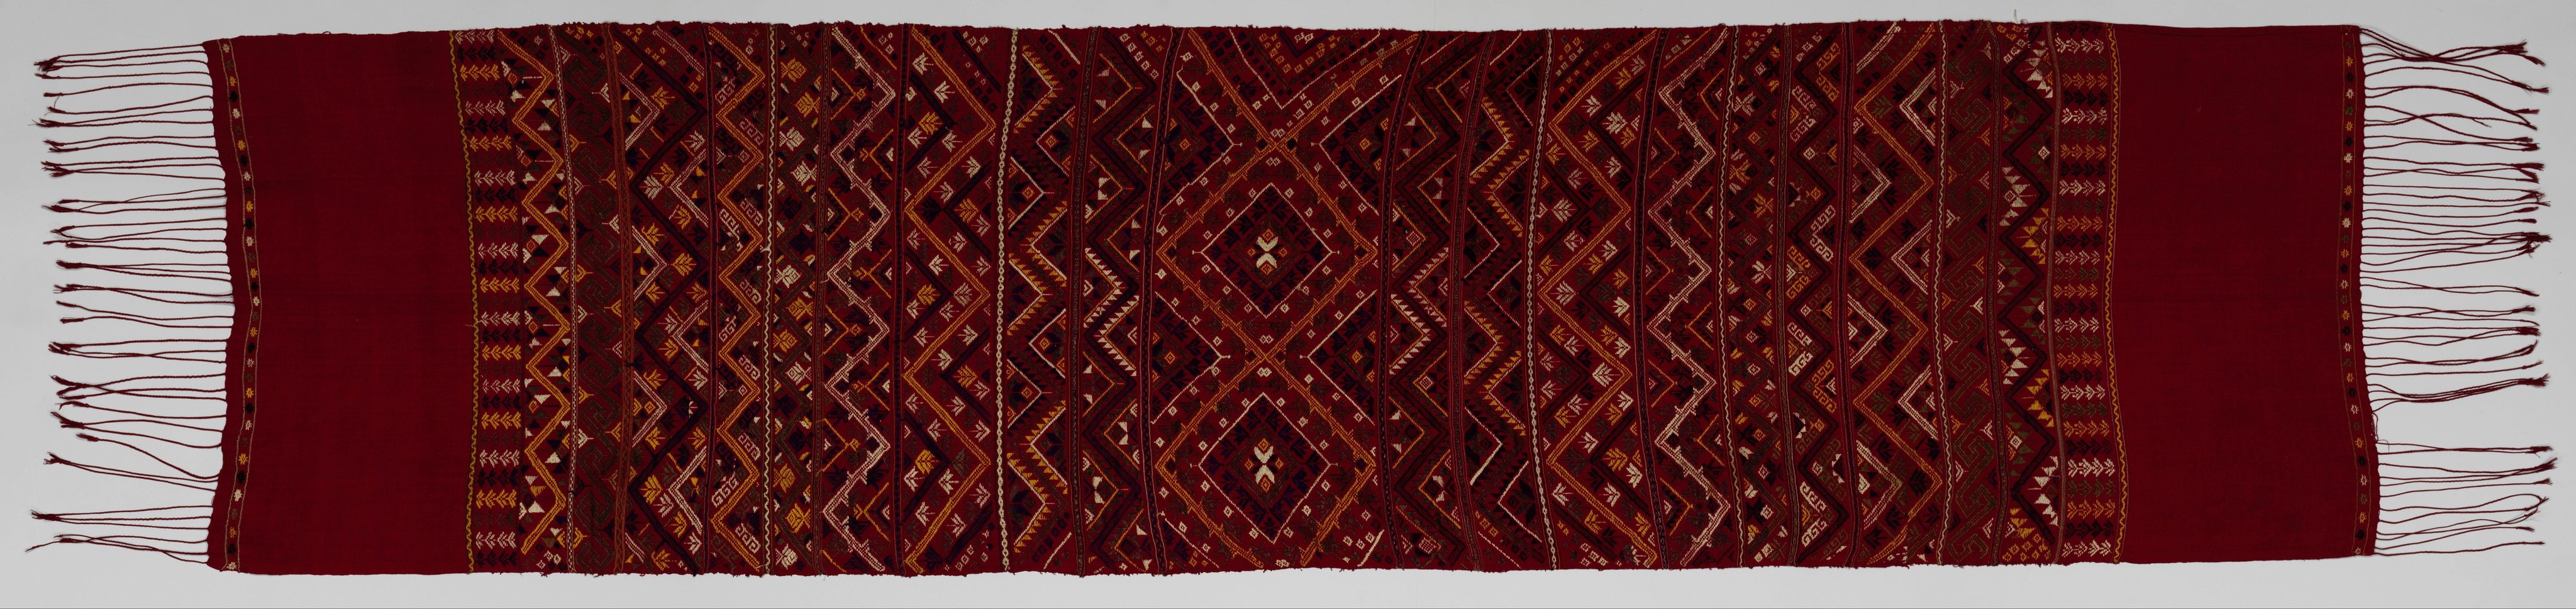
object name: cloth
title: Doek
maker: Anonymous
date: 1900-1949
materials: cotton, silk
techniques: weave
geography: thailand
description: Doek met florale en geometrische motieven.